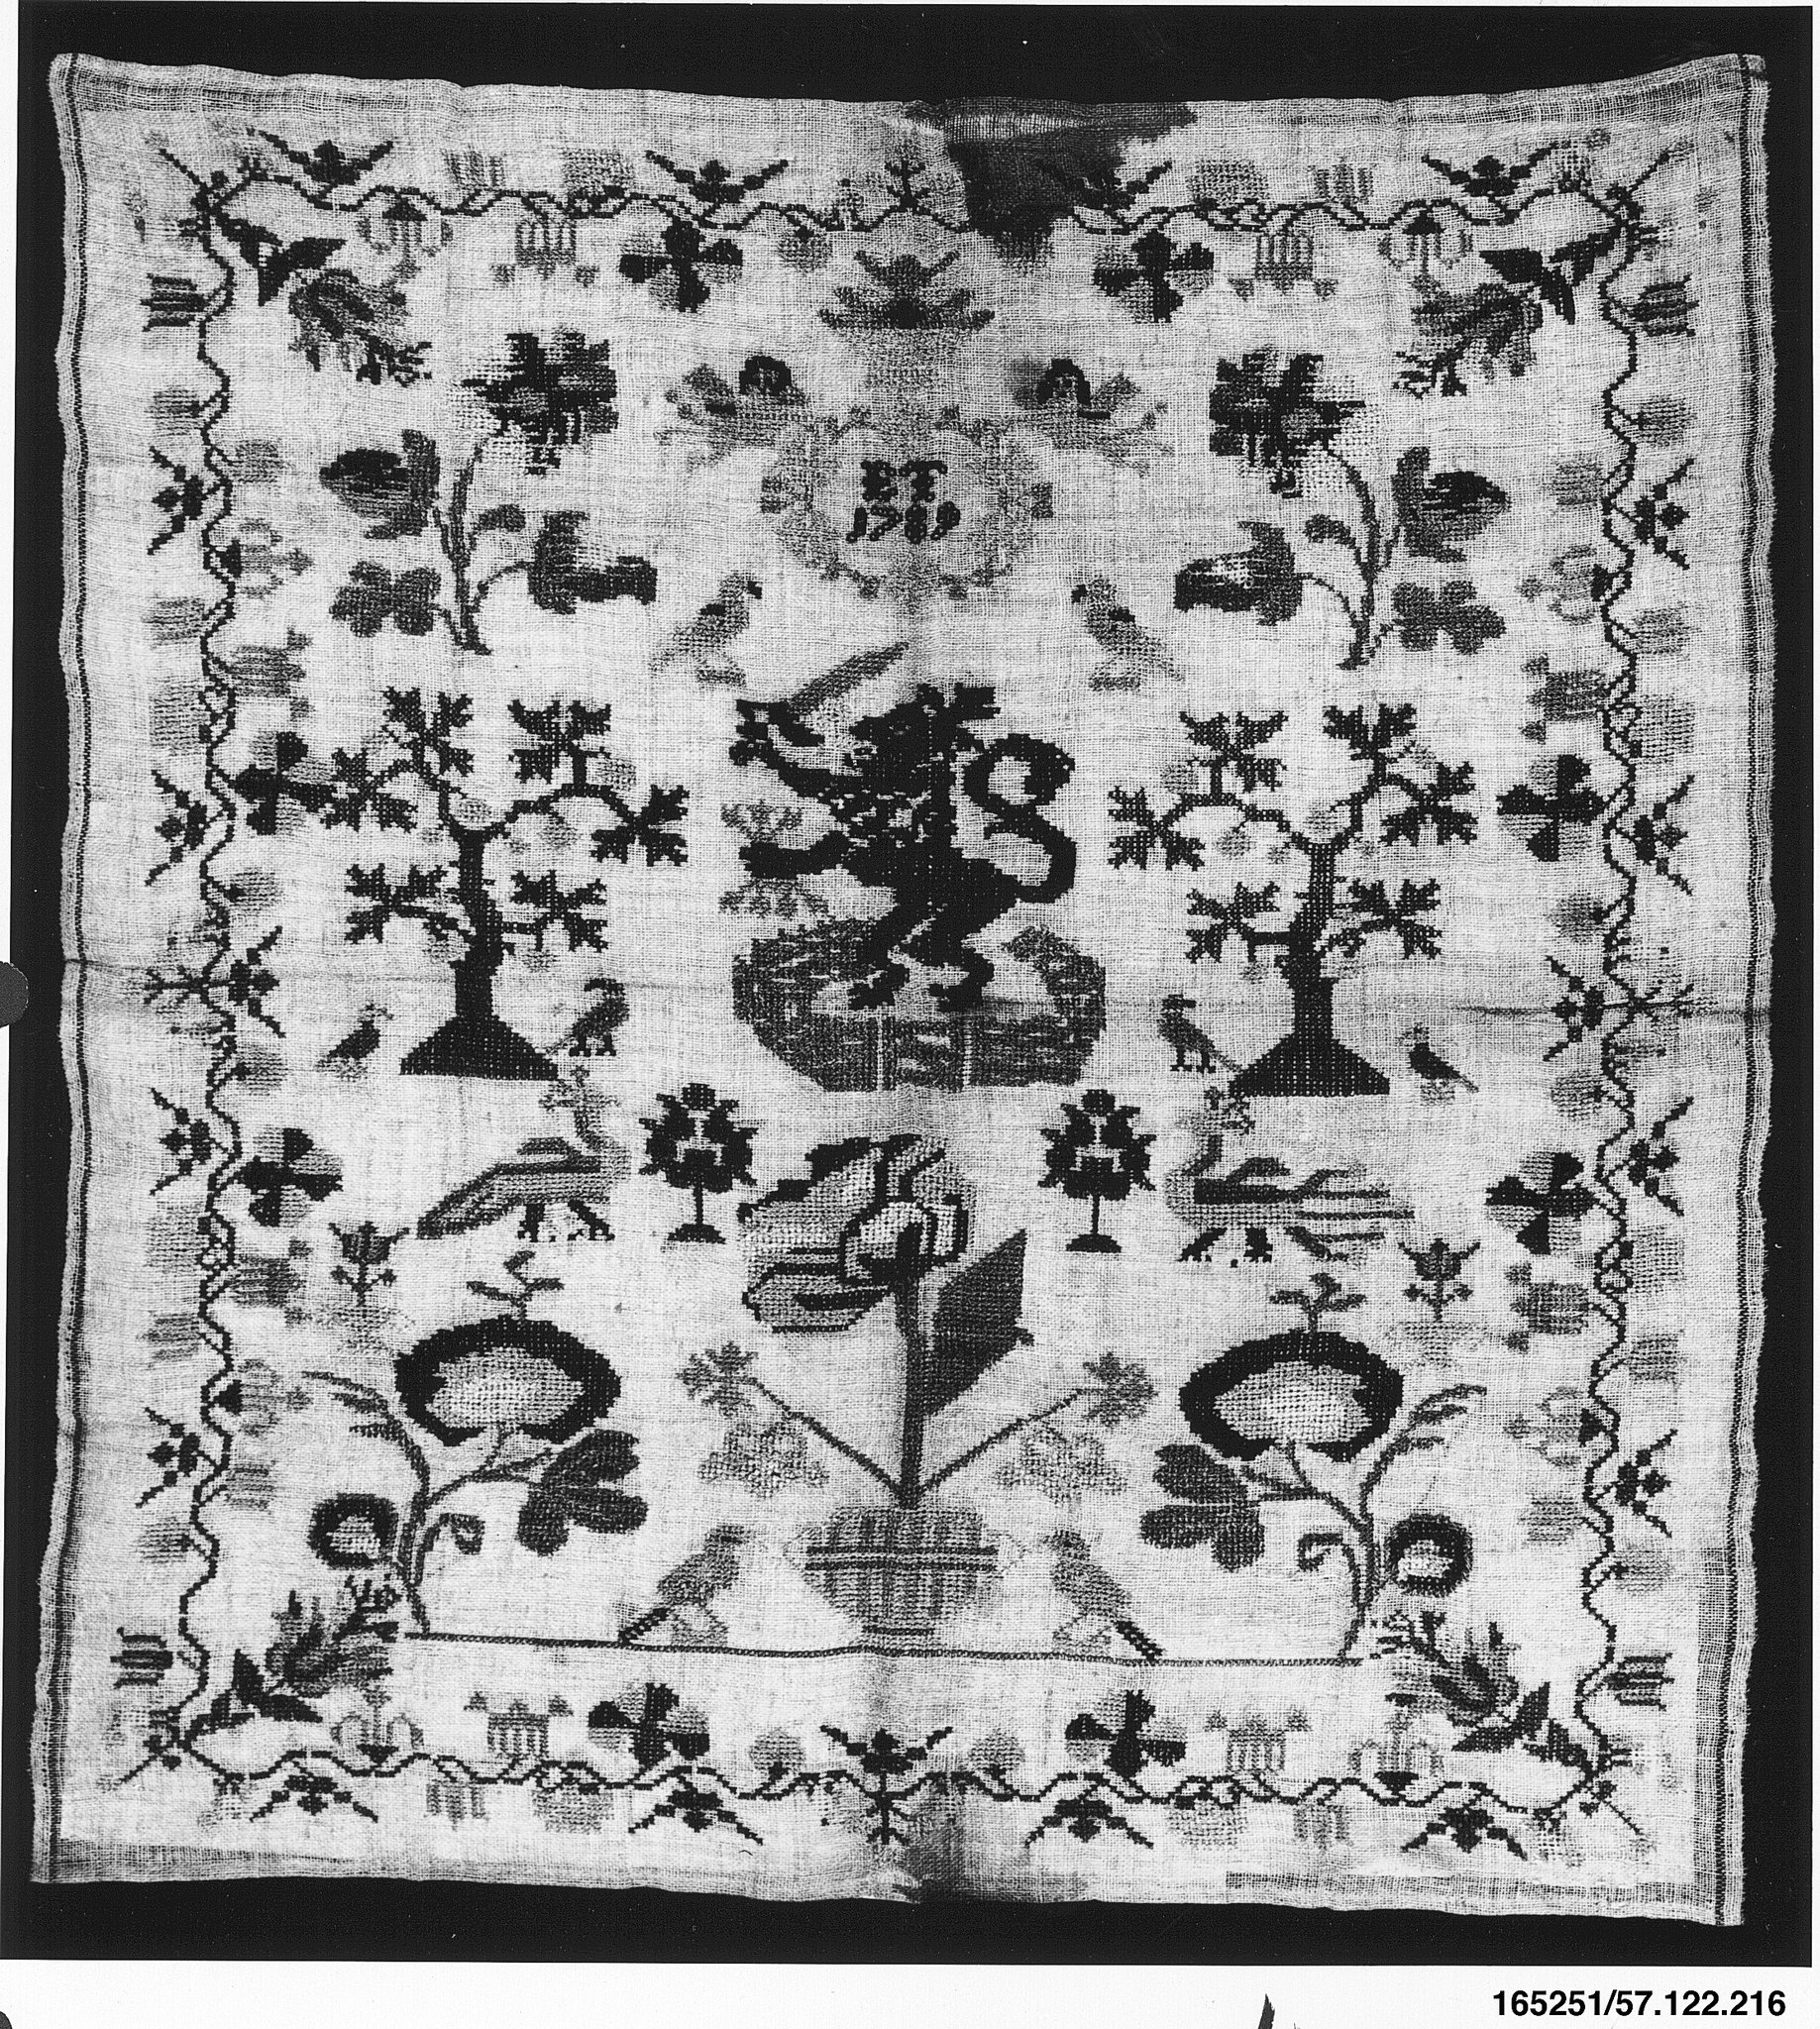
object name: sampler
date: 1789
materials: canvas, silk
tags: birds,lions,flowers,trees